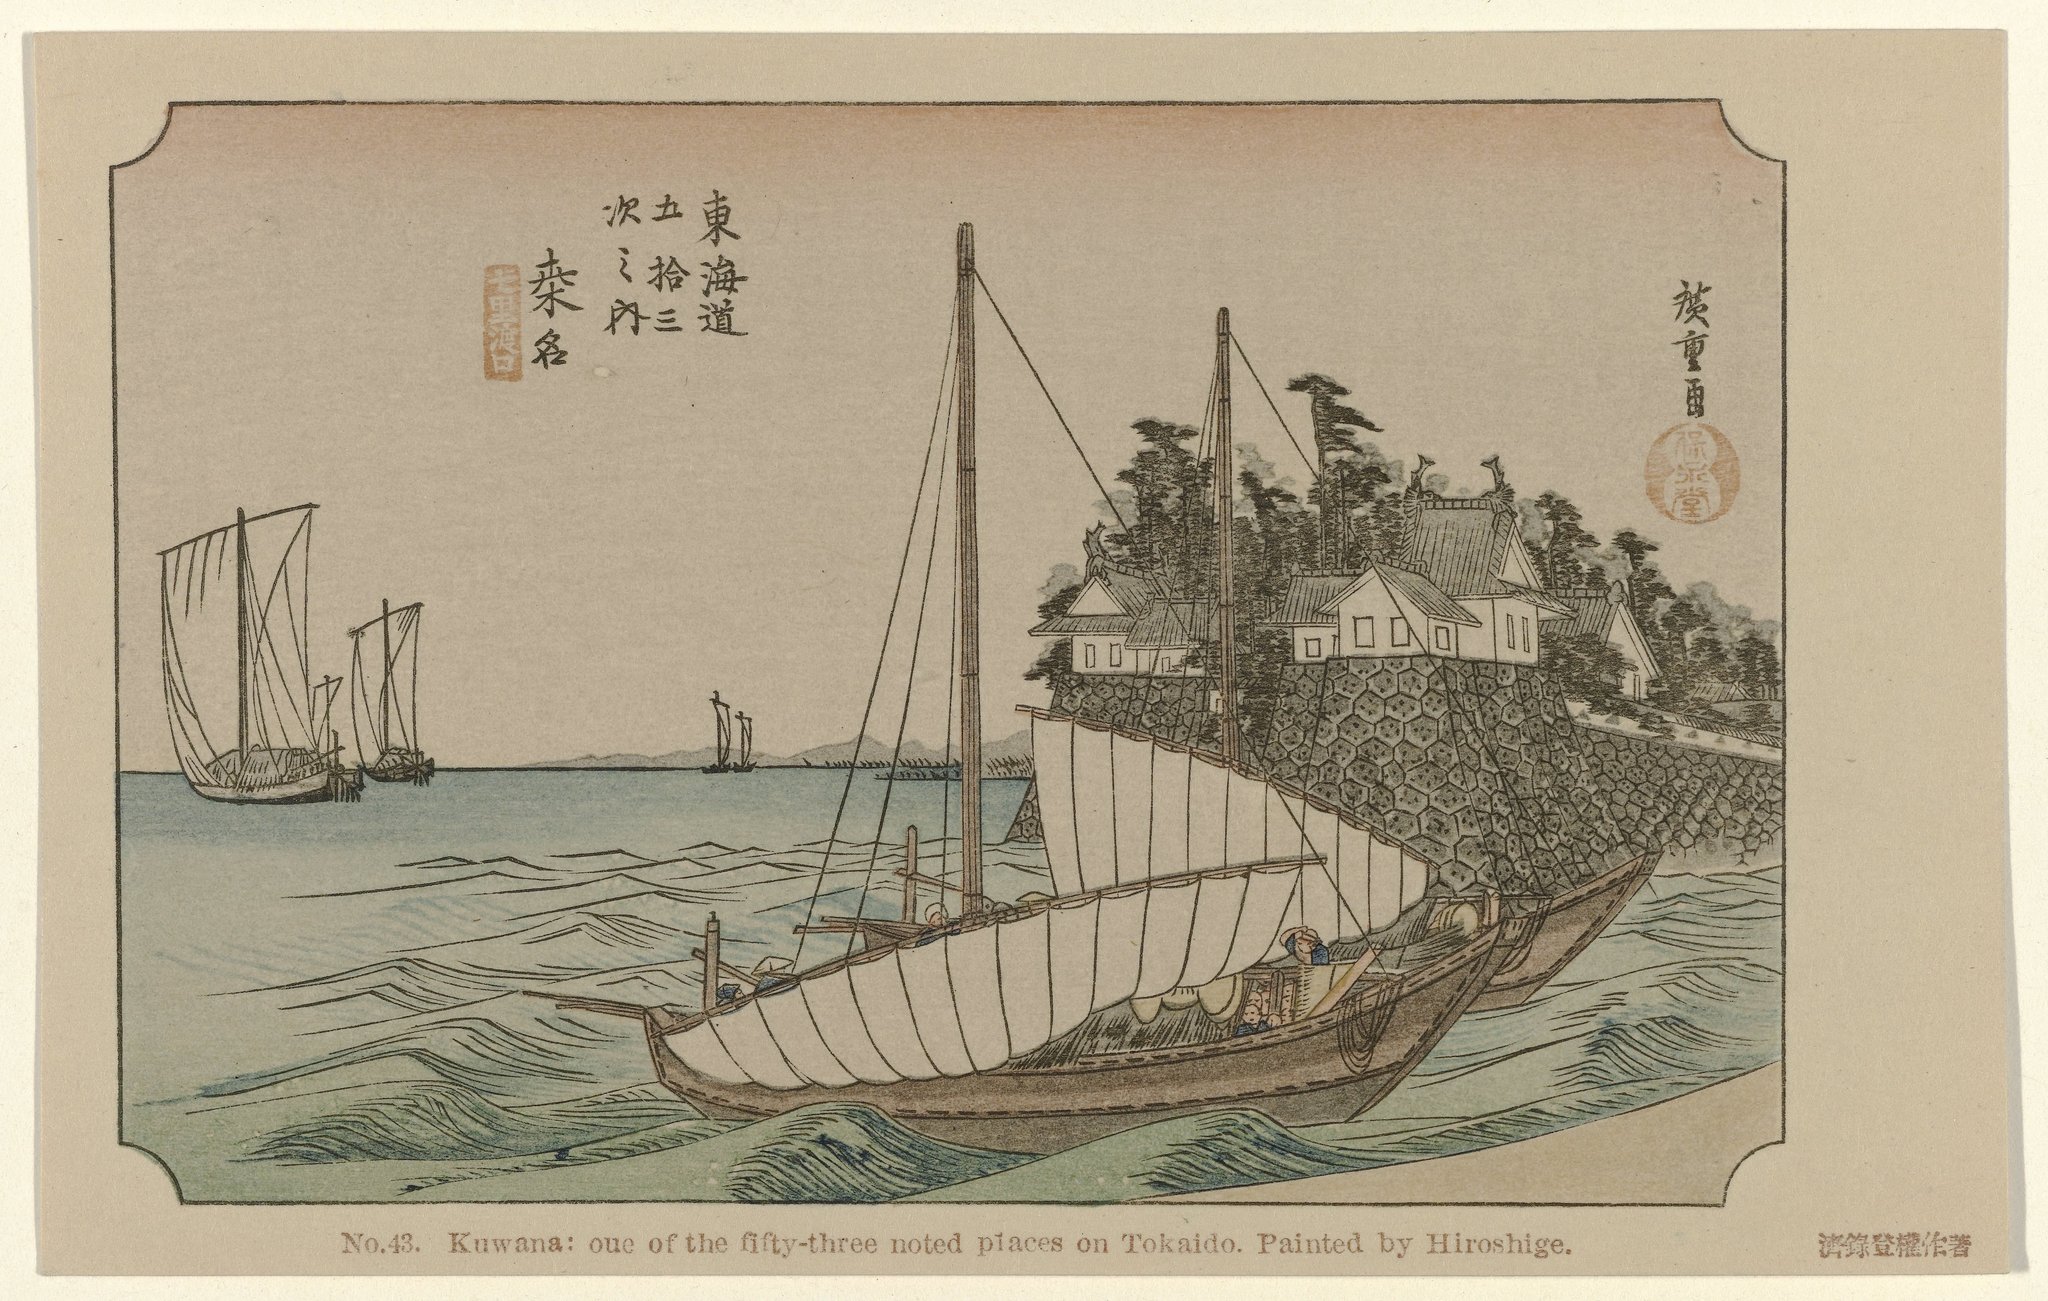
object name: ansichtkaart, prentbriefkaart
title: No. 43. Kuwana: one of the fifty-three noted places on Tokaido, painted by Hiroshige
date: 1906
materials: cardboard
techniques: woodcut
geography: japan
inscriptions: date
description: Twee grote schepen liggen bij de uitmonding van de Kiso rivier.